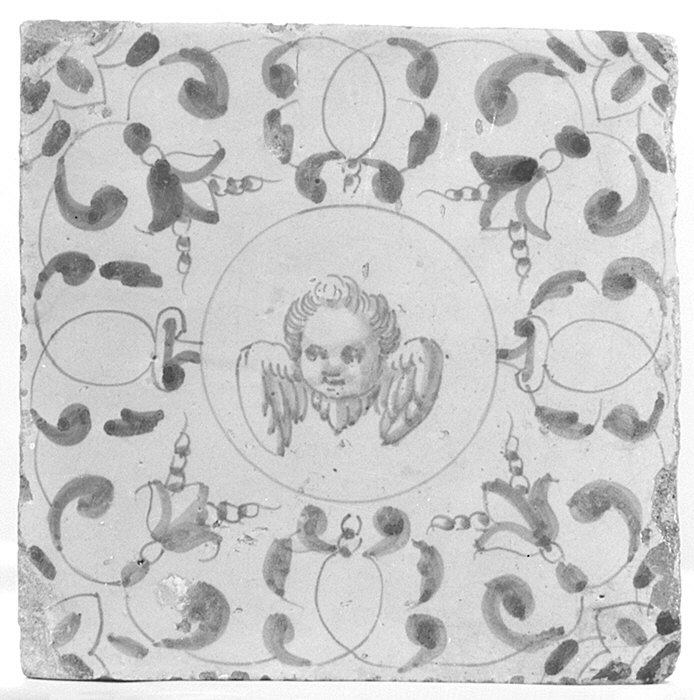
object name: tile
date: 1620-1640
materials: earthenware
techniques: glazing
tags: faces